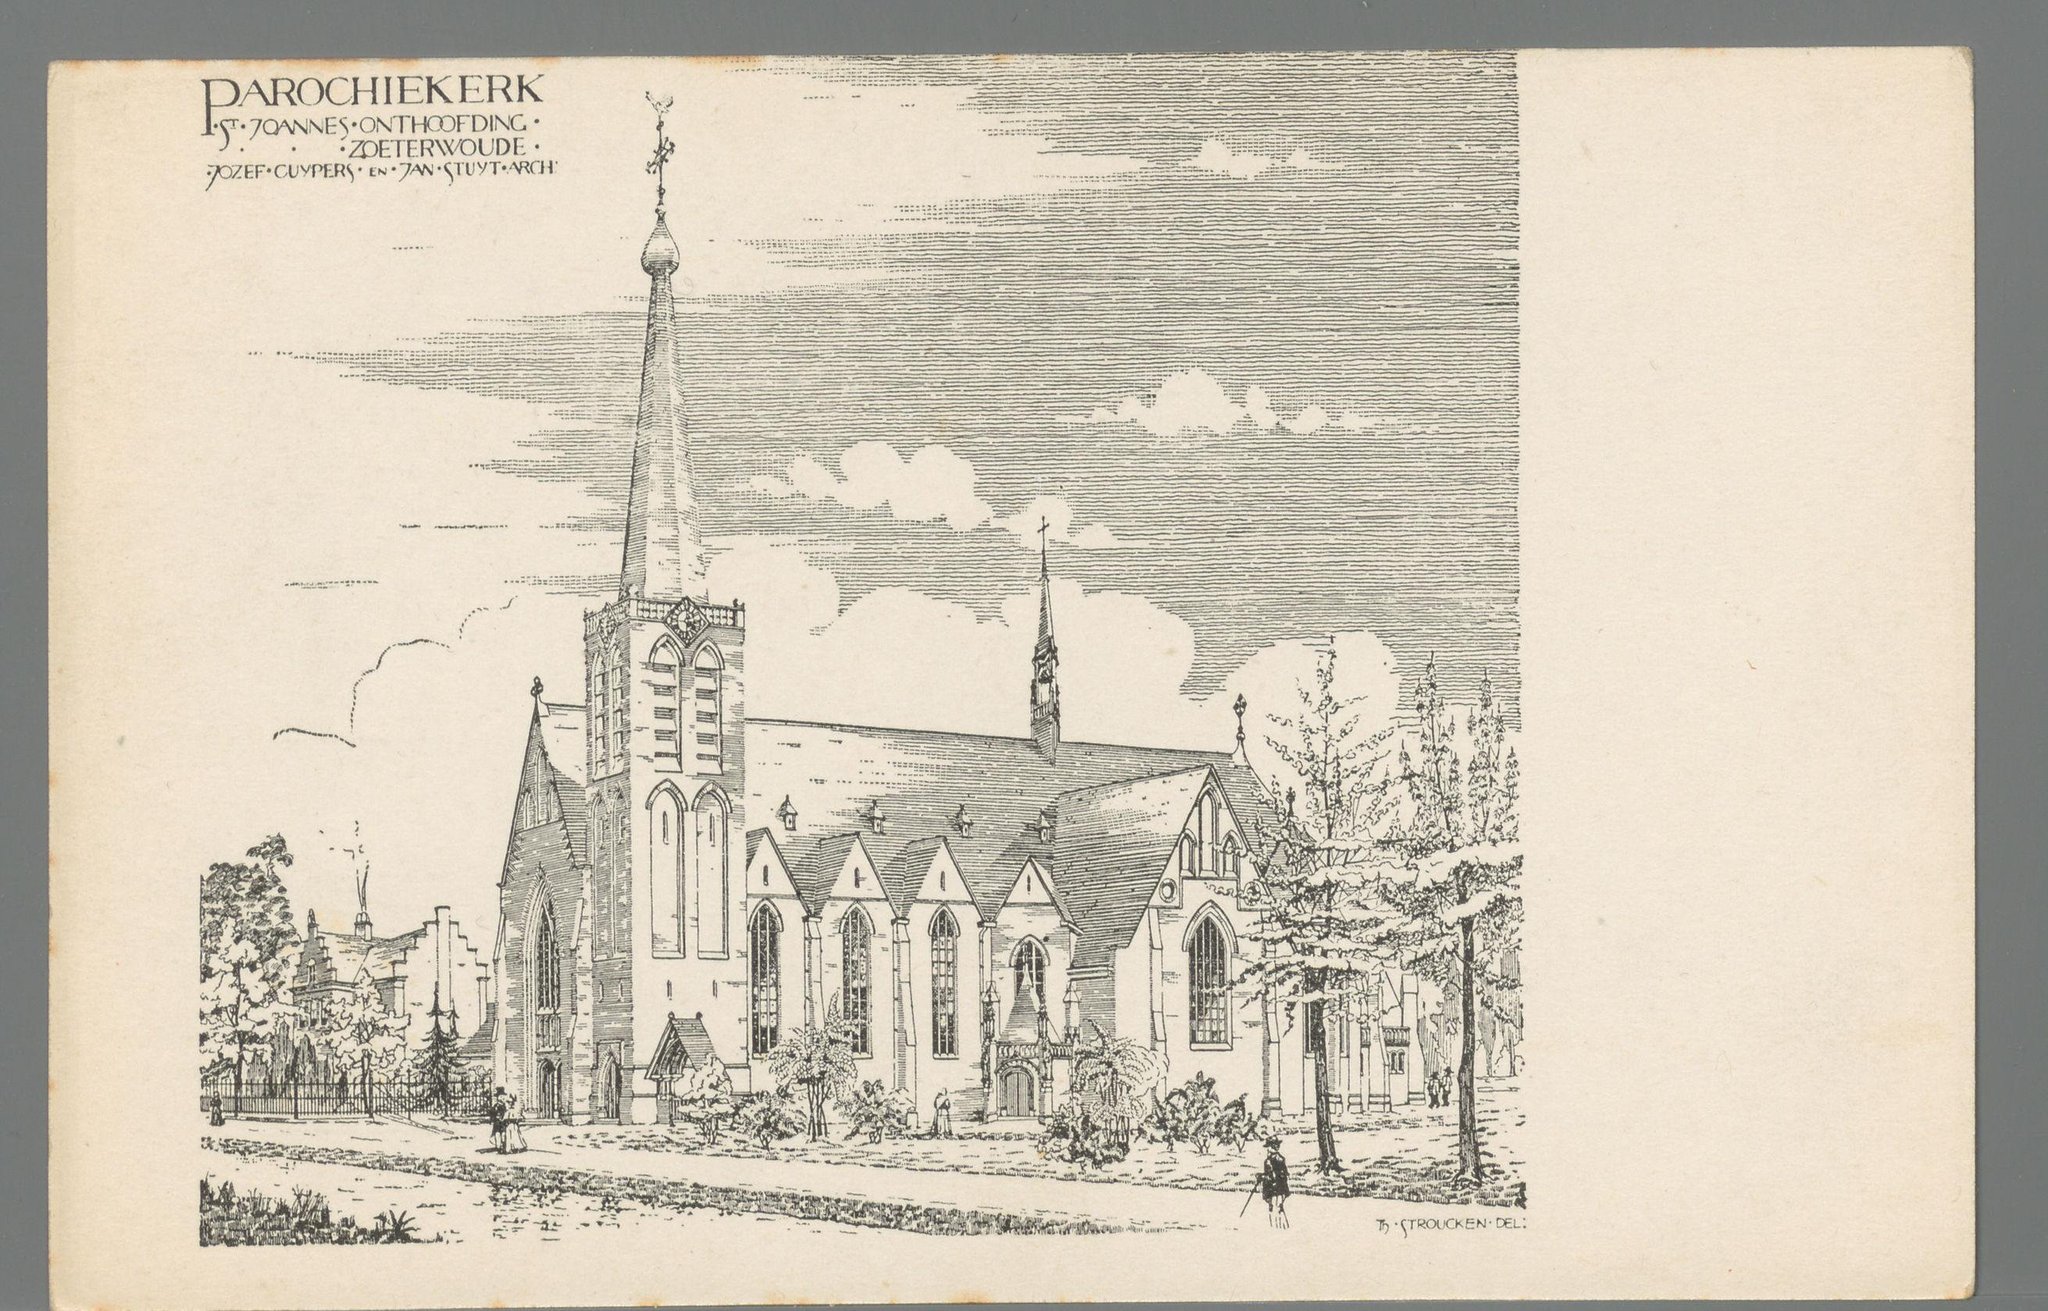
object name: ansichtkaart, prentbriefkaart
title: Parochiekerk St. Joannes Onthoofding. Zoeterwoude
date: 1892-1905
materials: cardboard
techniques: printing block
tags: church (exterior)